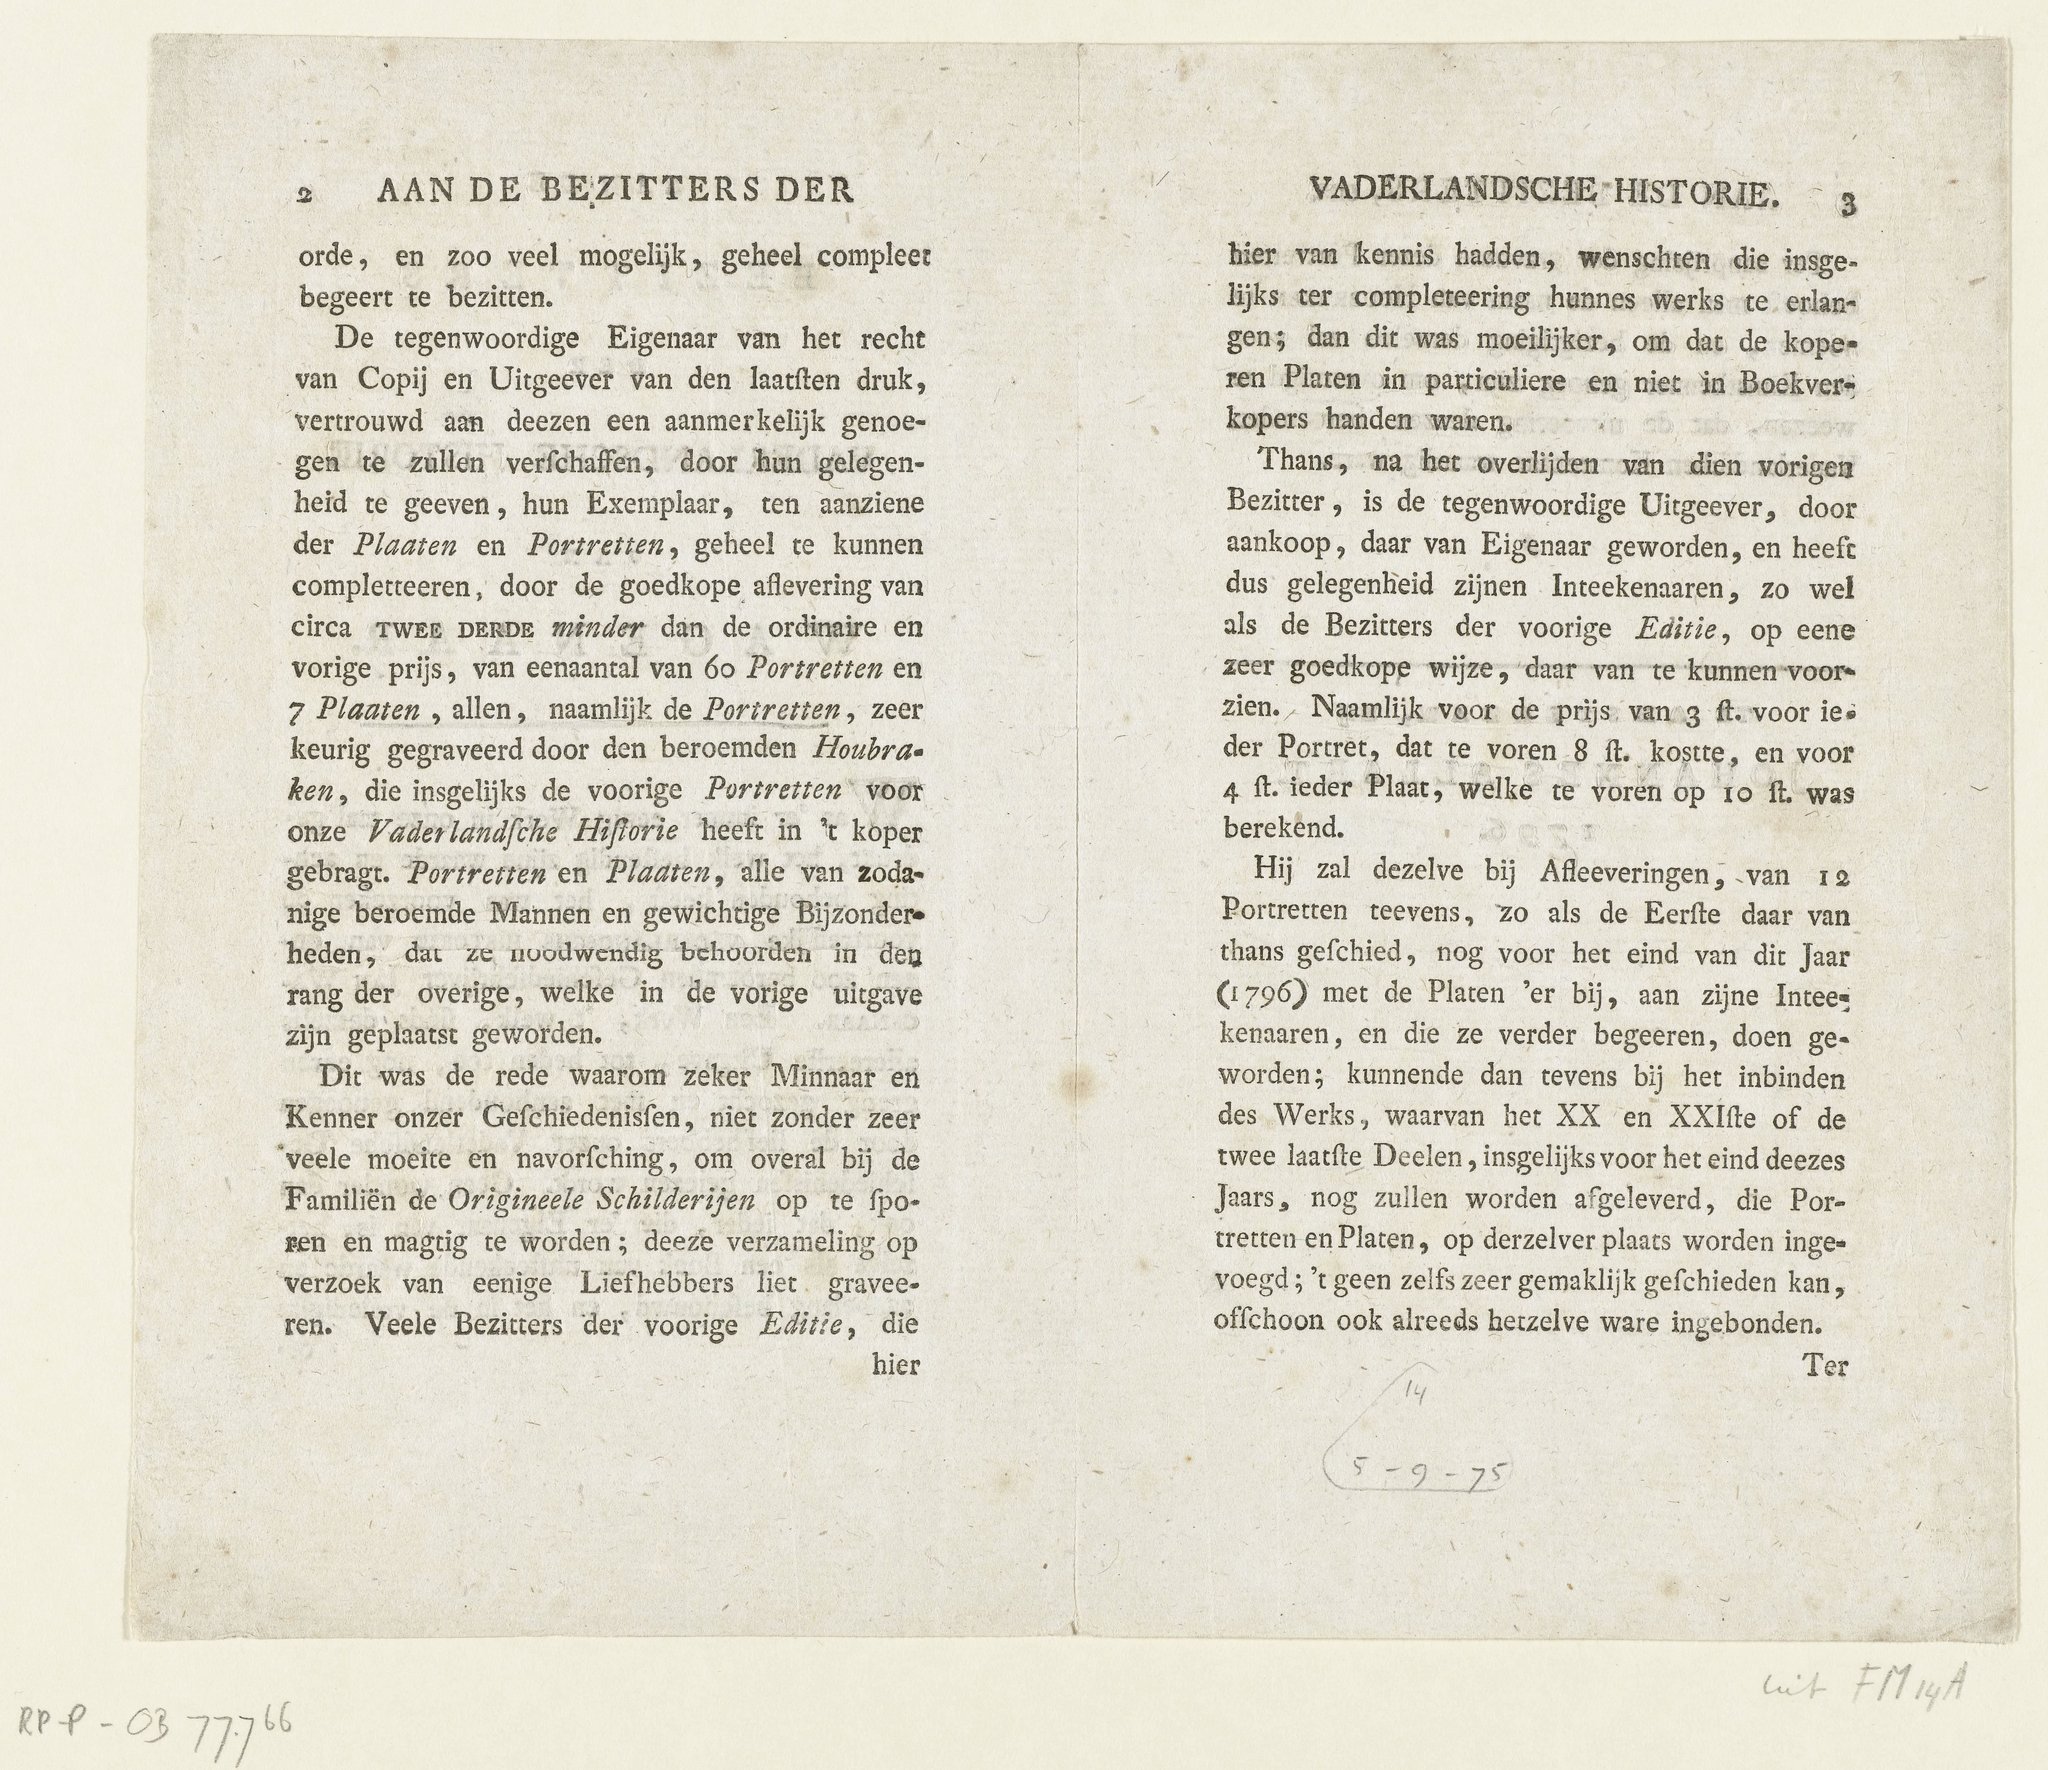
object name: uitgeversbrochure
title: Aan de bezitters der Vaderlandsche Historie van Wagenaar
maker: johannes allart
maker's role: publisher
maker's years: 1754-1816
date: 1796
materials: paper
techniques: letterpress printing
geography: amsterdam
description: Vier bladzijden waarin de uitgever Johannes Allart illustraties bij Wagenaars Vaderlandsche Historie aanbiedt tegen gereduceerde prijzen.